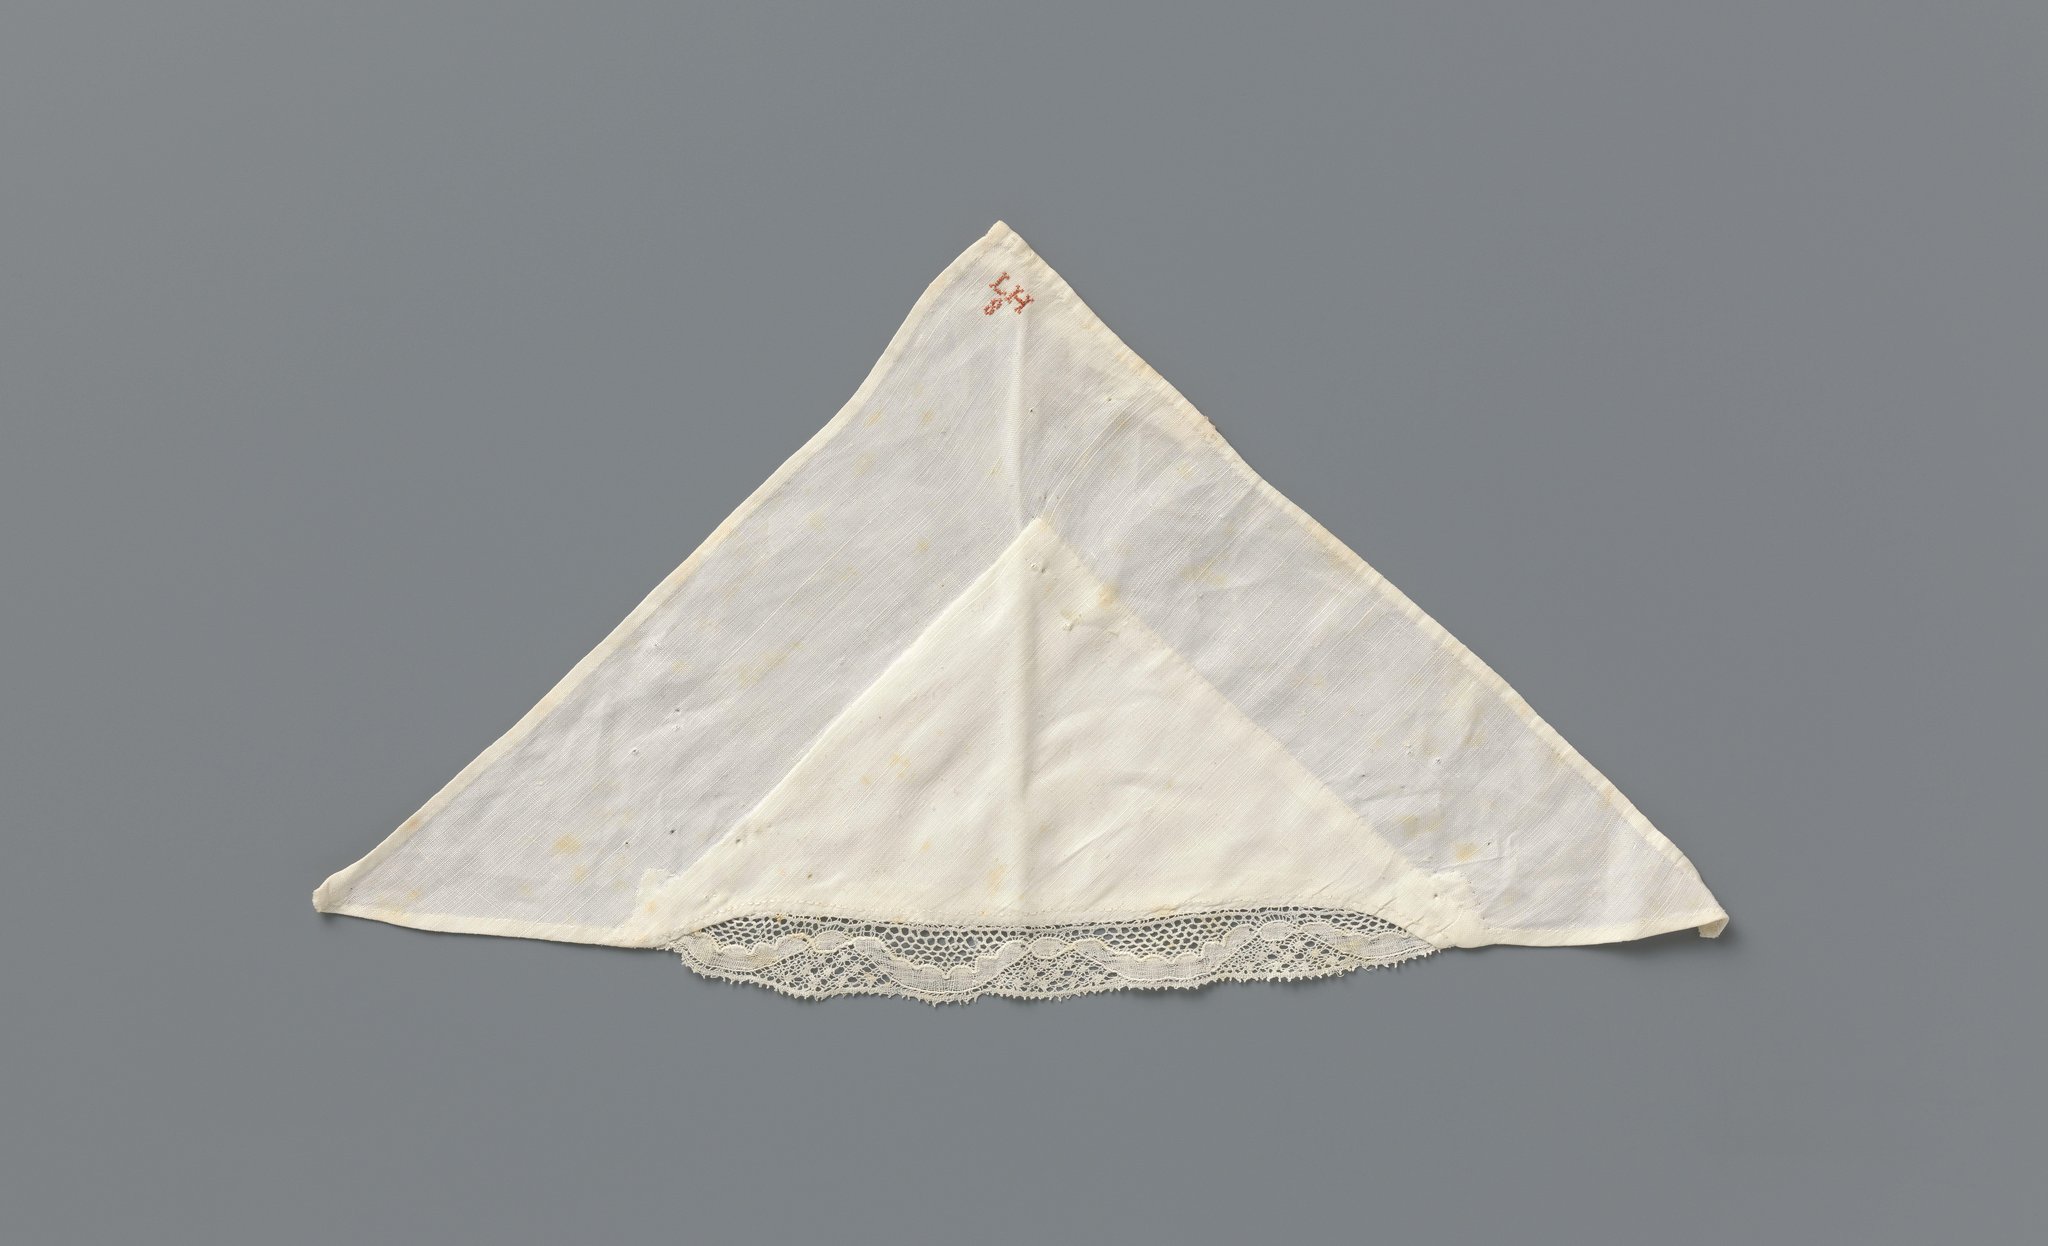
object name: fontaneldoek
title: Fontaneldoek van wit linnen met kant; in rode kruissteek gemerkt: LH8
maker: Anonymous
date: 1750-1900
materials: linen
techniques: cross stitching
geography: europe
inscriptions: inscription: ‘LH / 8’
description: 12 linnen fontanelletjes met verschillende kant afgezet , 4 gemerkt LH8, 3 gem. H8, 5 gem. HVS(Gr. Hoogenhuize "1772-1852" tr. 1802 S.E. von schmid "1771-1843"). 1 van damast gem. HH6 (W.r. Hoogenhuize "1747-1804" tr 1787 W. Helmerich "1752").